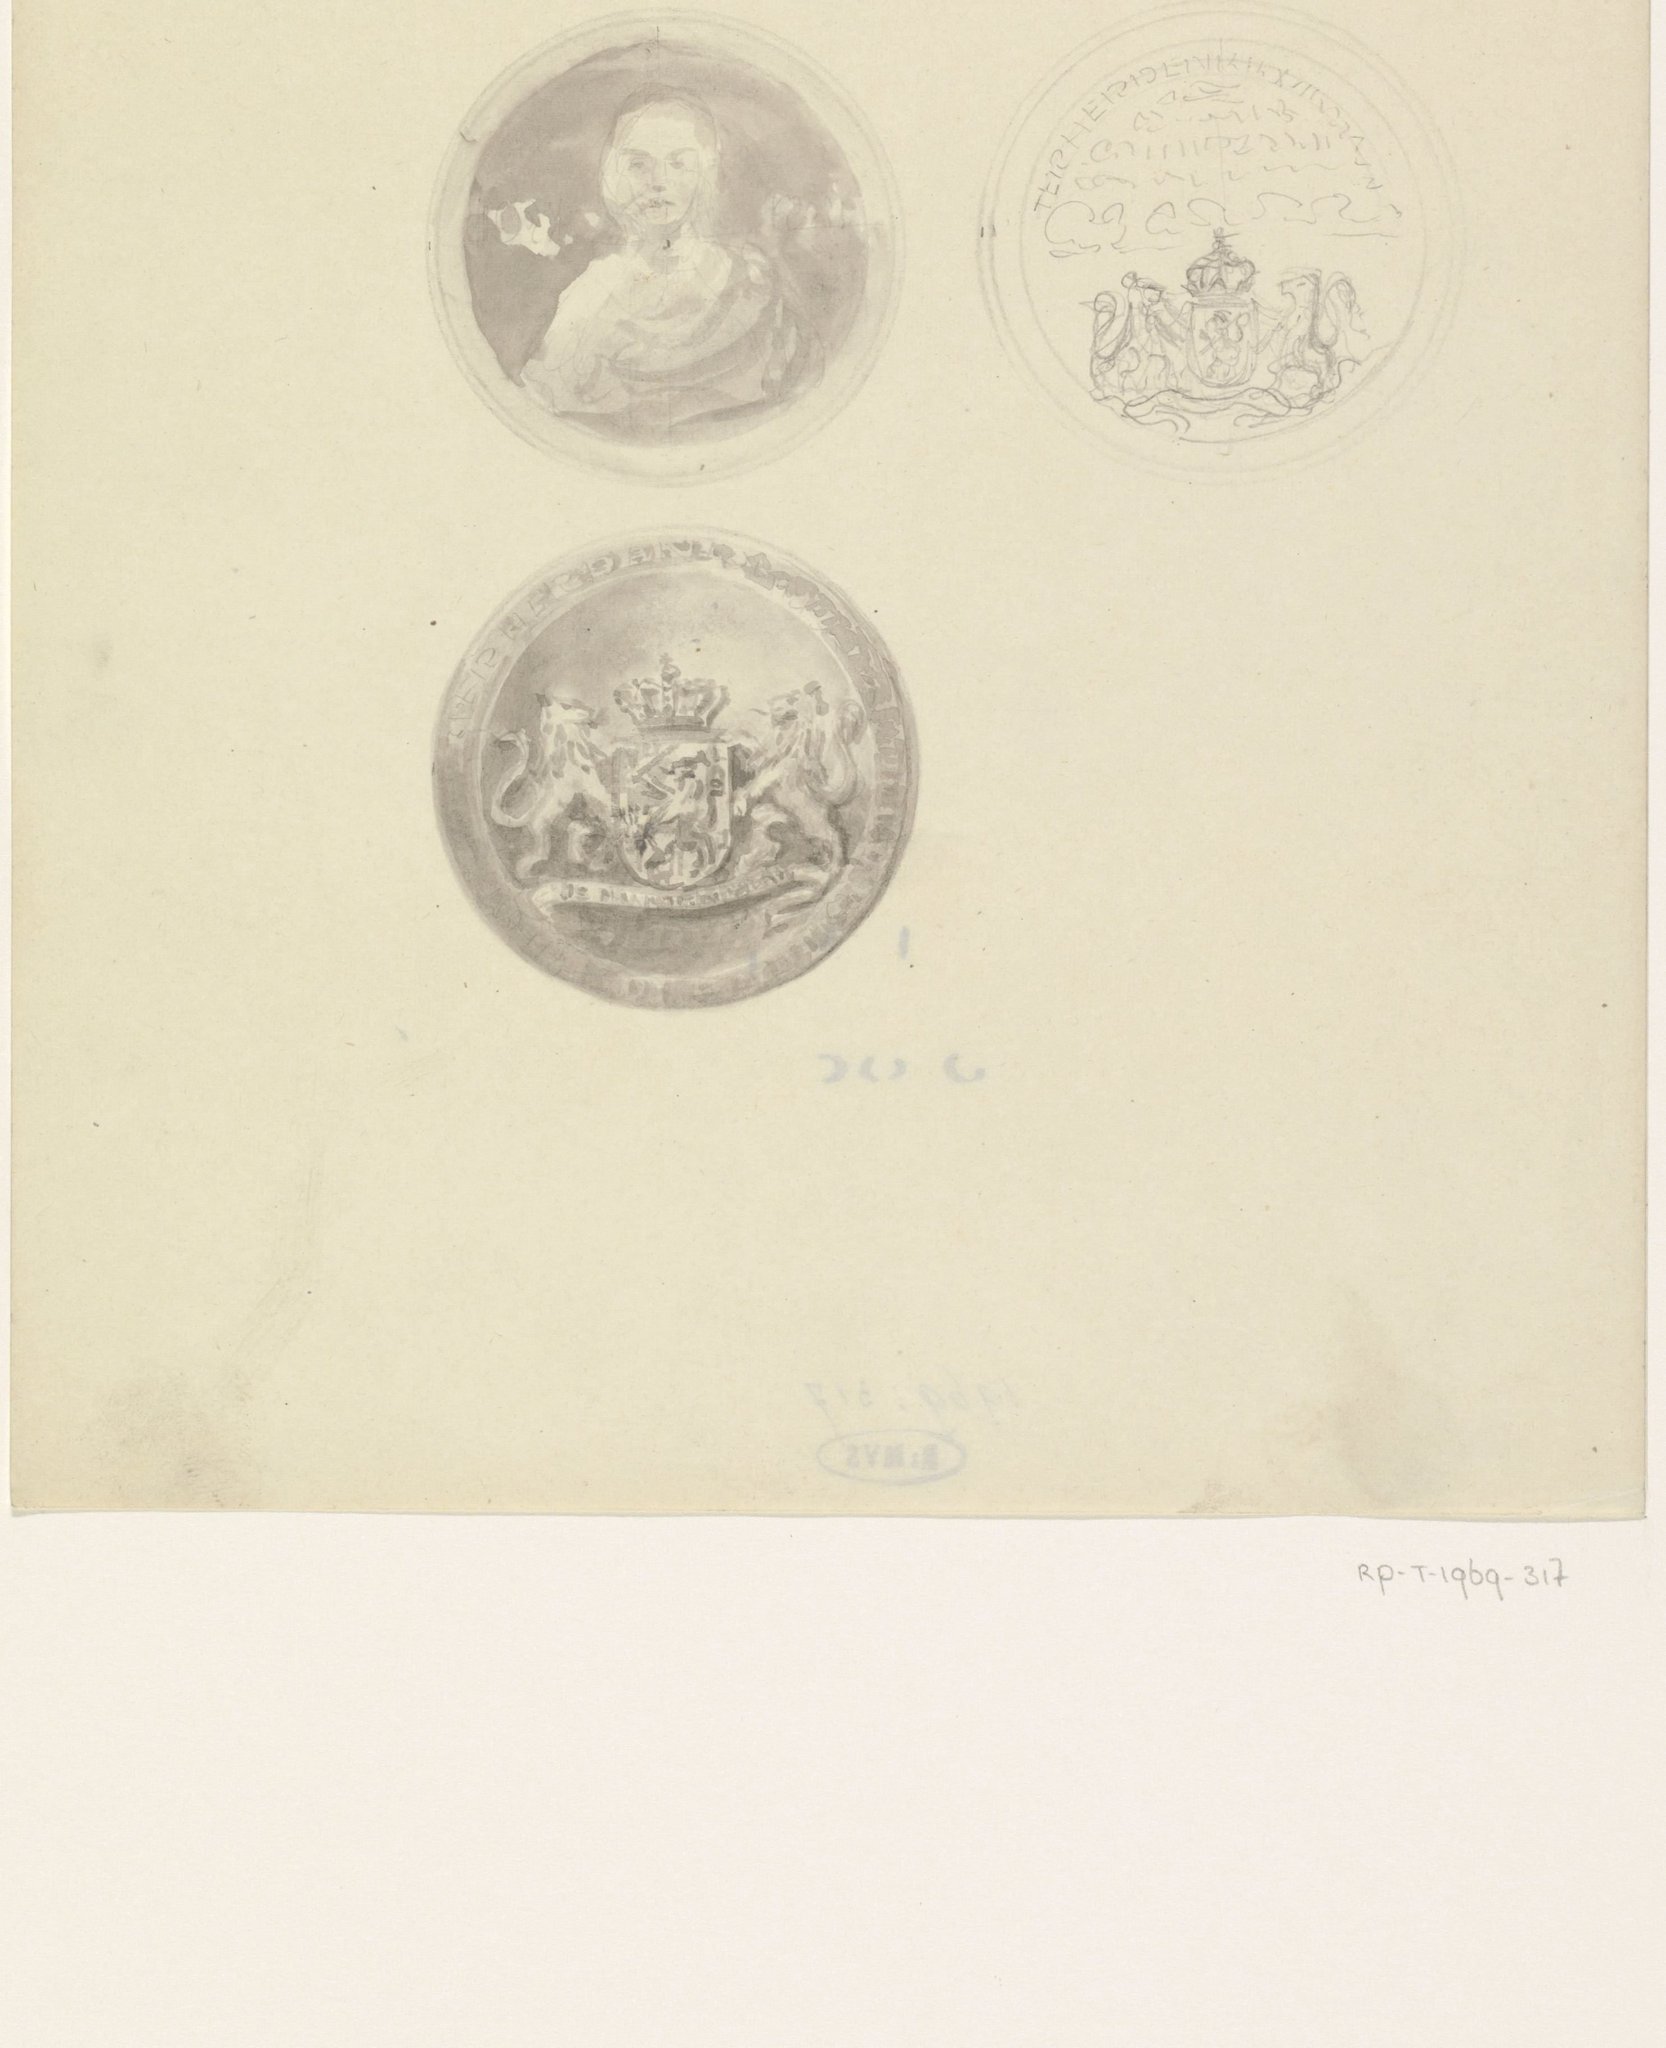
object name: design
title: Ontwerpen voor een penning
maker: carel adolph lion cachet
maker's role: draughtsman, print maker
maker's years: 1864-1945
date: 1874-1945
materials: paper, pencil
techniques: brush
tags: medal (considered as a piece of sculpture, regardless of its specific function)